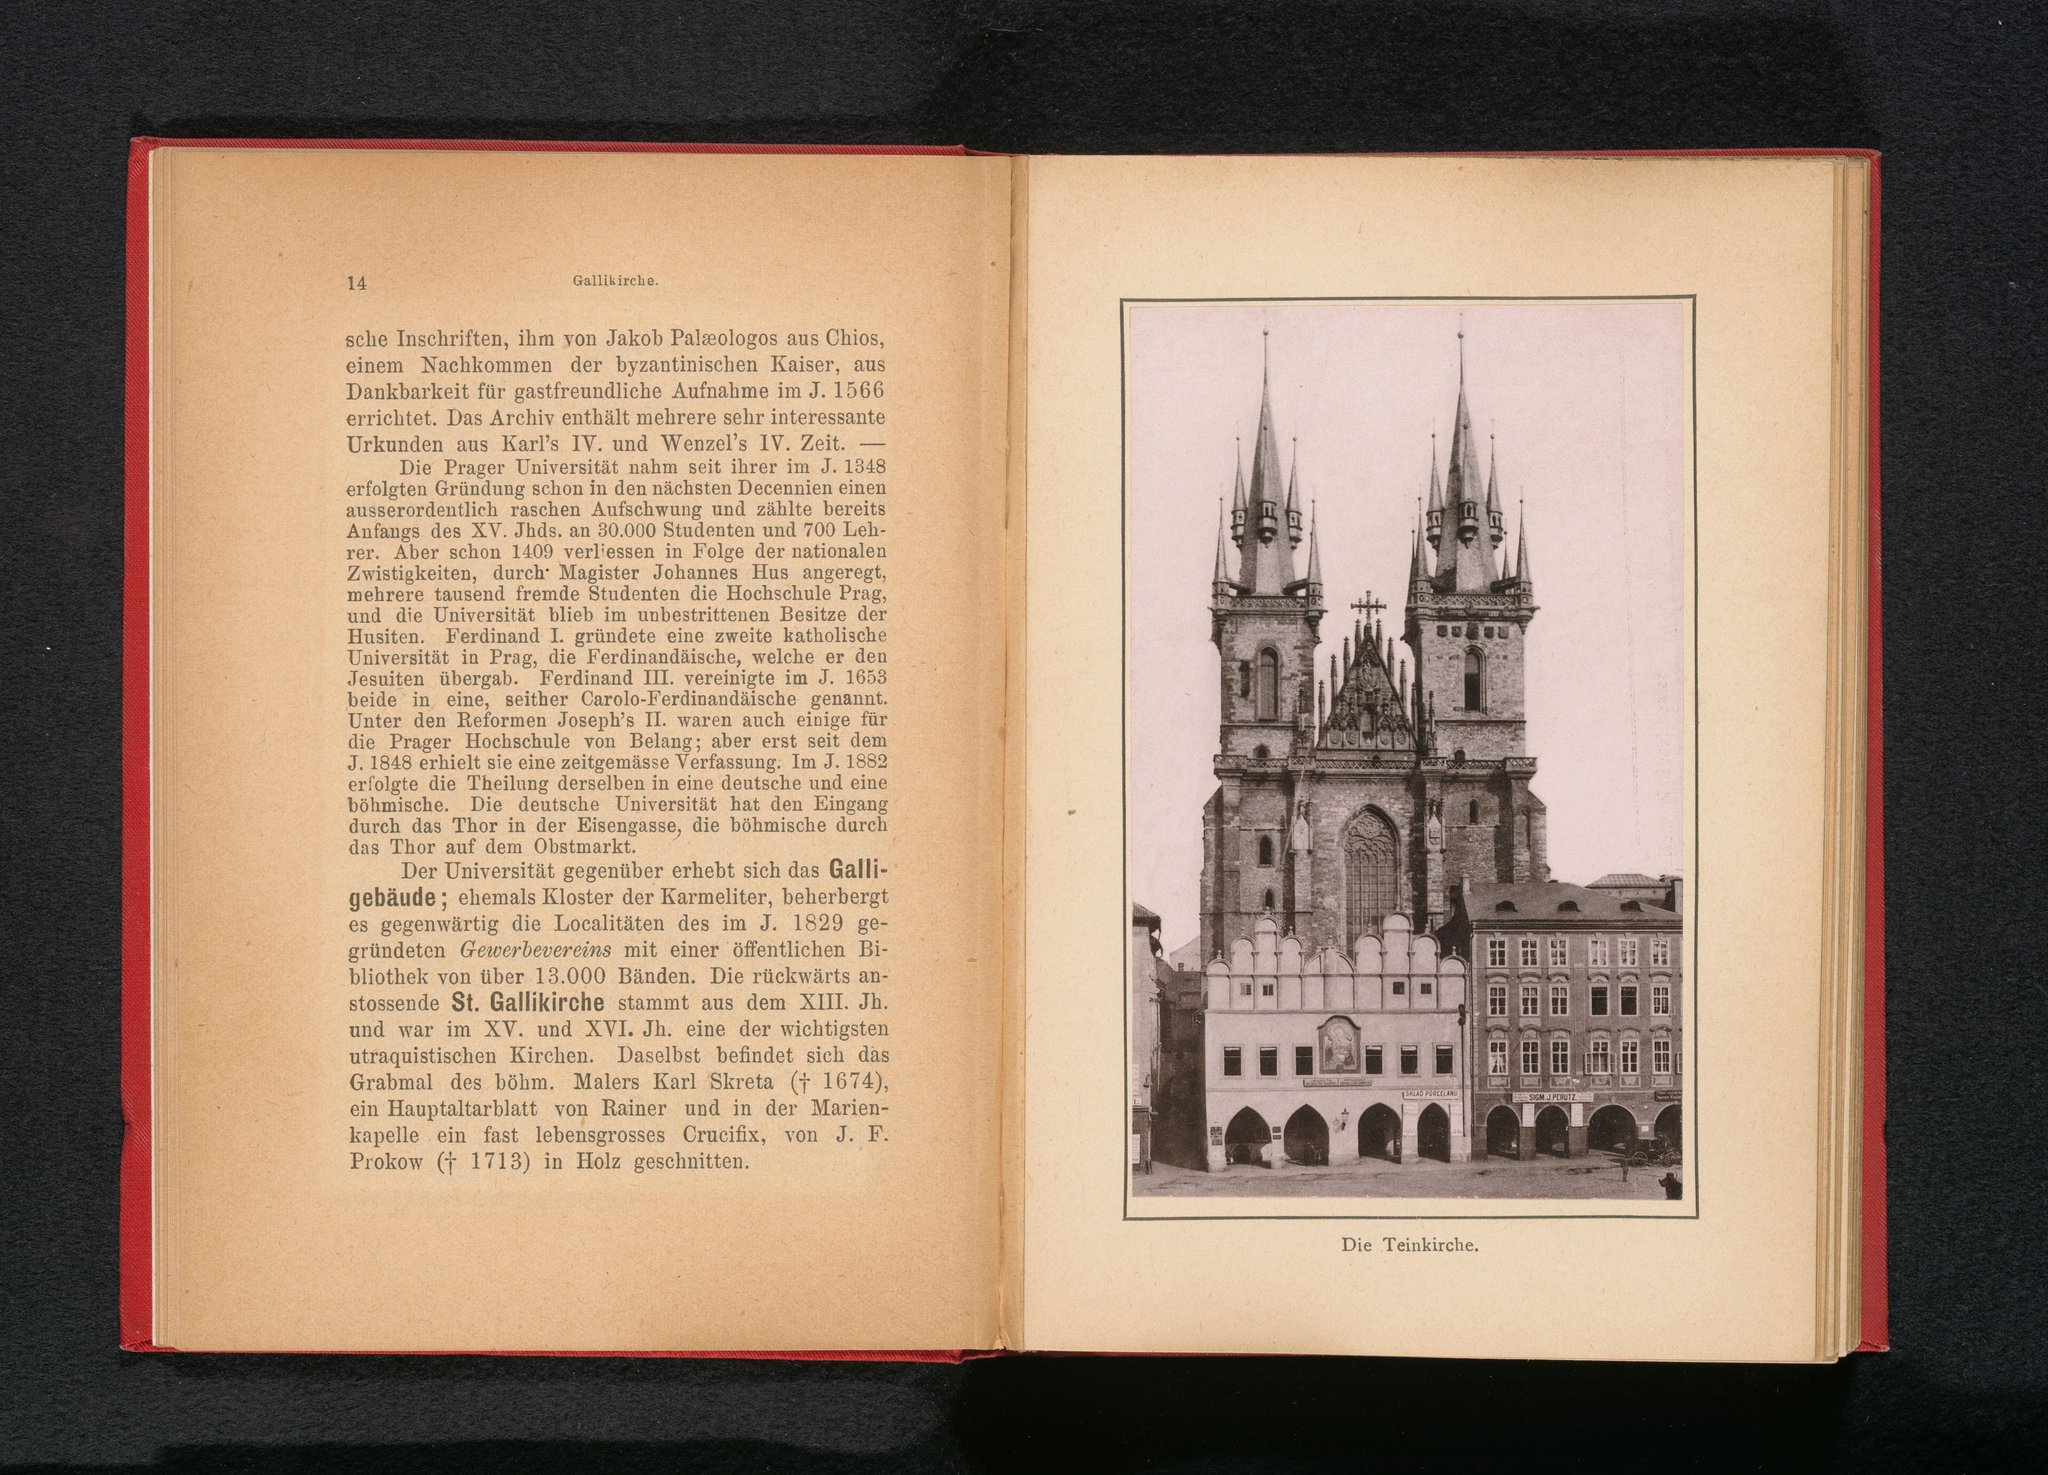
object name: page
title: Die Teinkirche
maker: Anonymous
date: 1885-1890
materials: paper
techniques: photograph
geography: prague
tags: church (exterior)